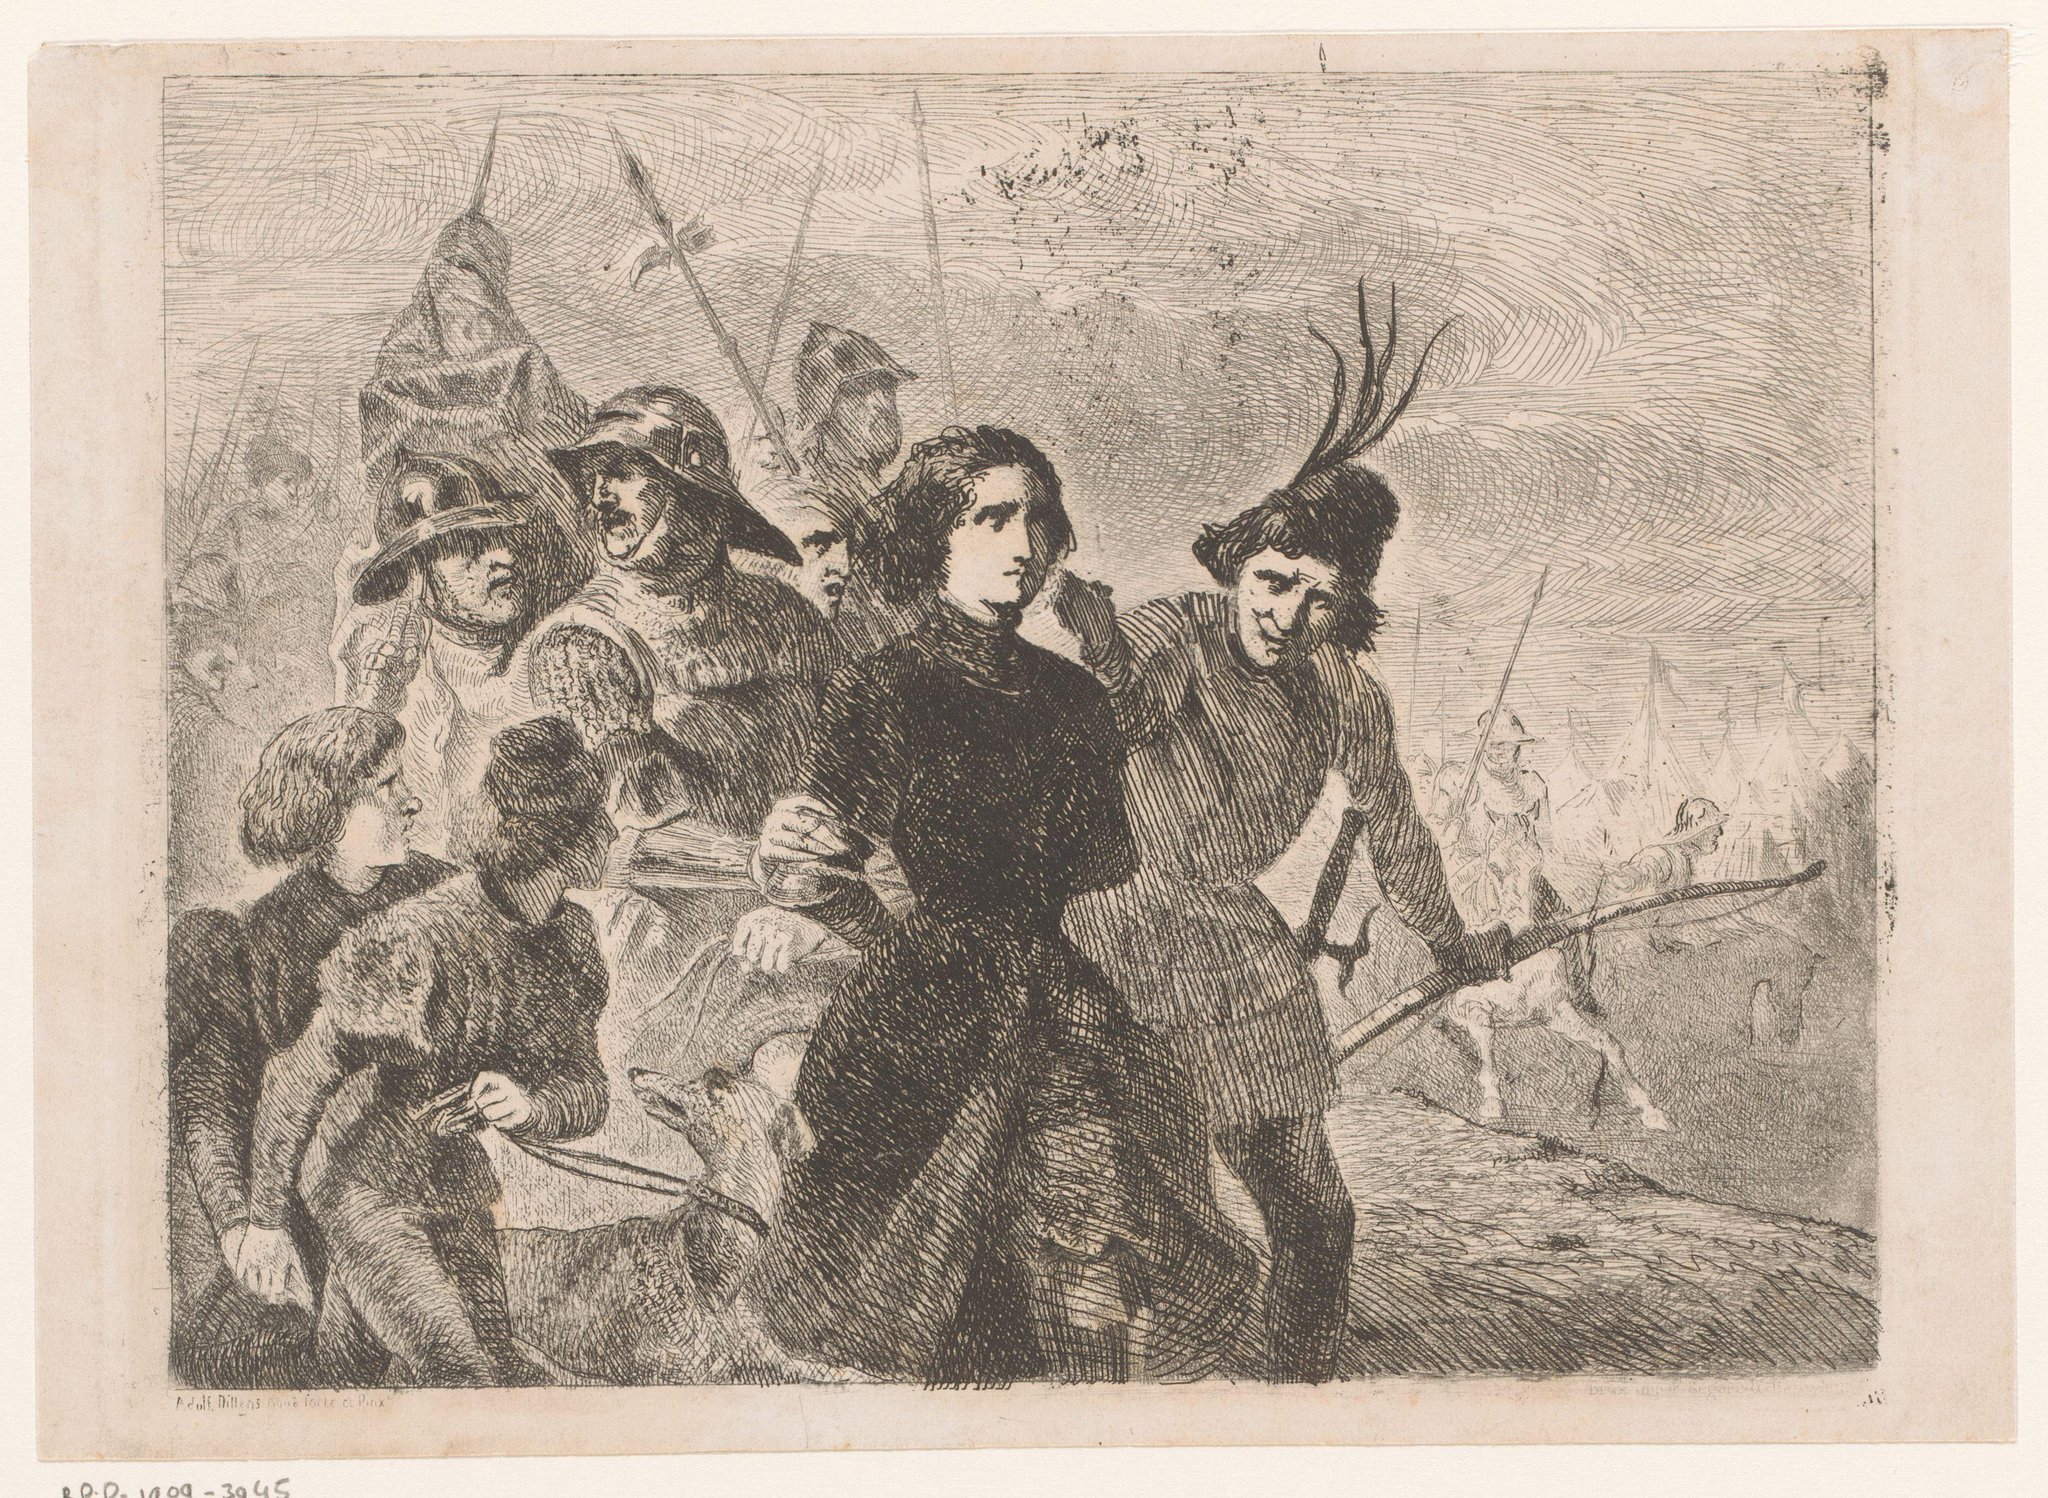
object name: print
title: Jeanne d'Arc wordt door soldaten gevangen en meegevoerd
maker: adolphe alexandre dillens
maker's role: draughtsman, painter, print maker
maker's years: 1821-1877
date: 1851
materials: paper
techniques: etching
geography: brussels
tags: joan of arc (jeanne d'arc); possible attributes: armour, banner, lance, sword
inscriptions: collector's mark: Lugt 2228